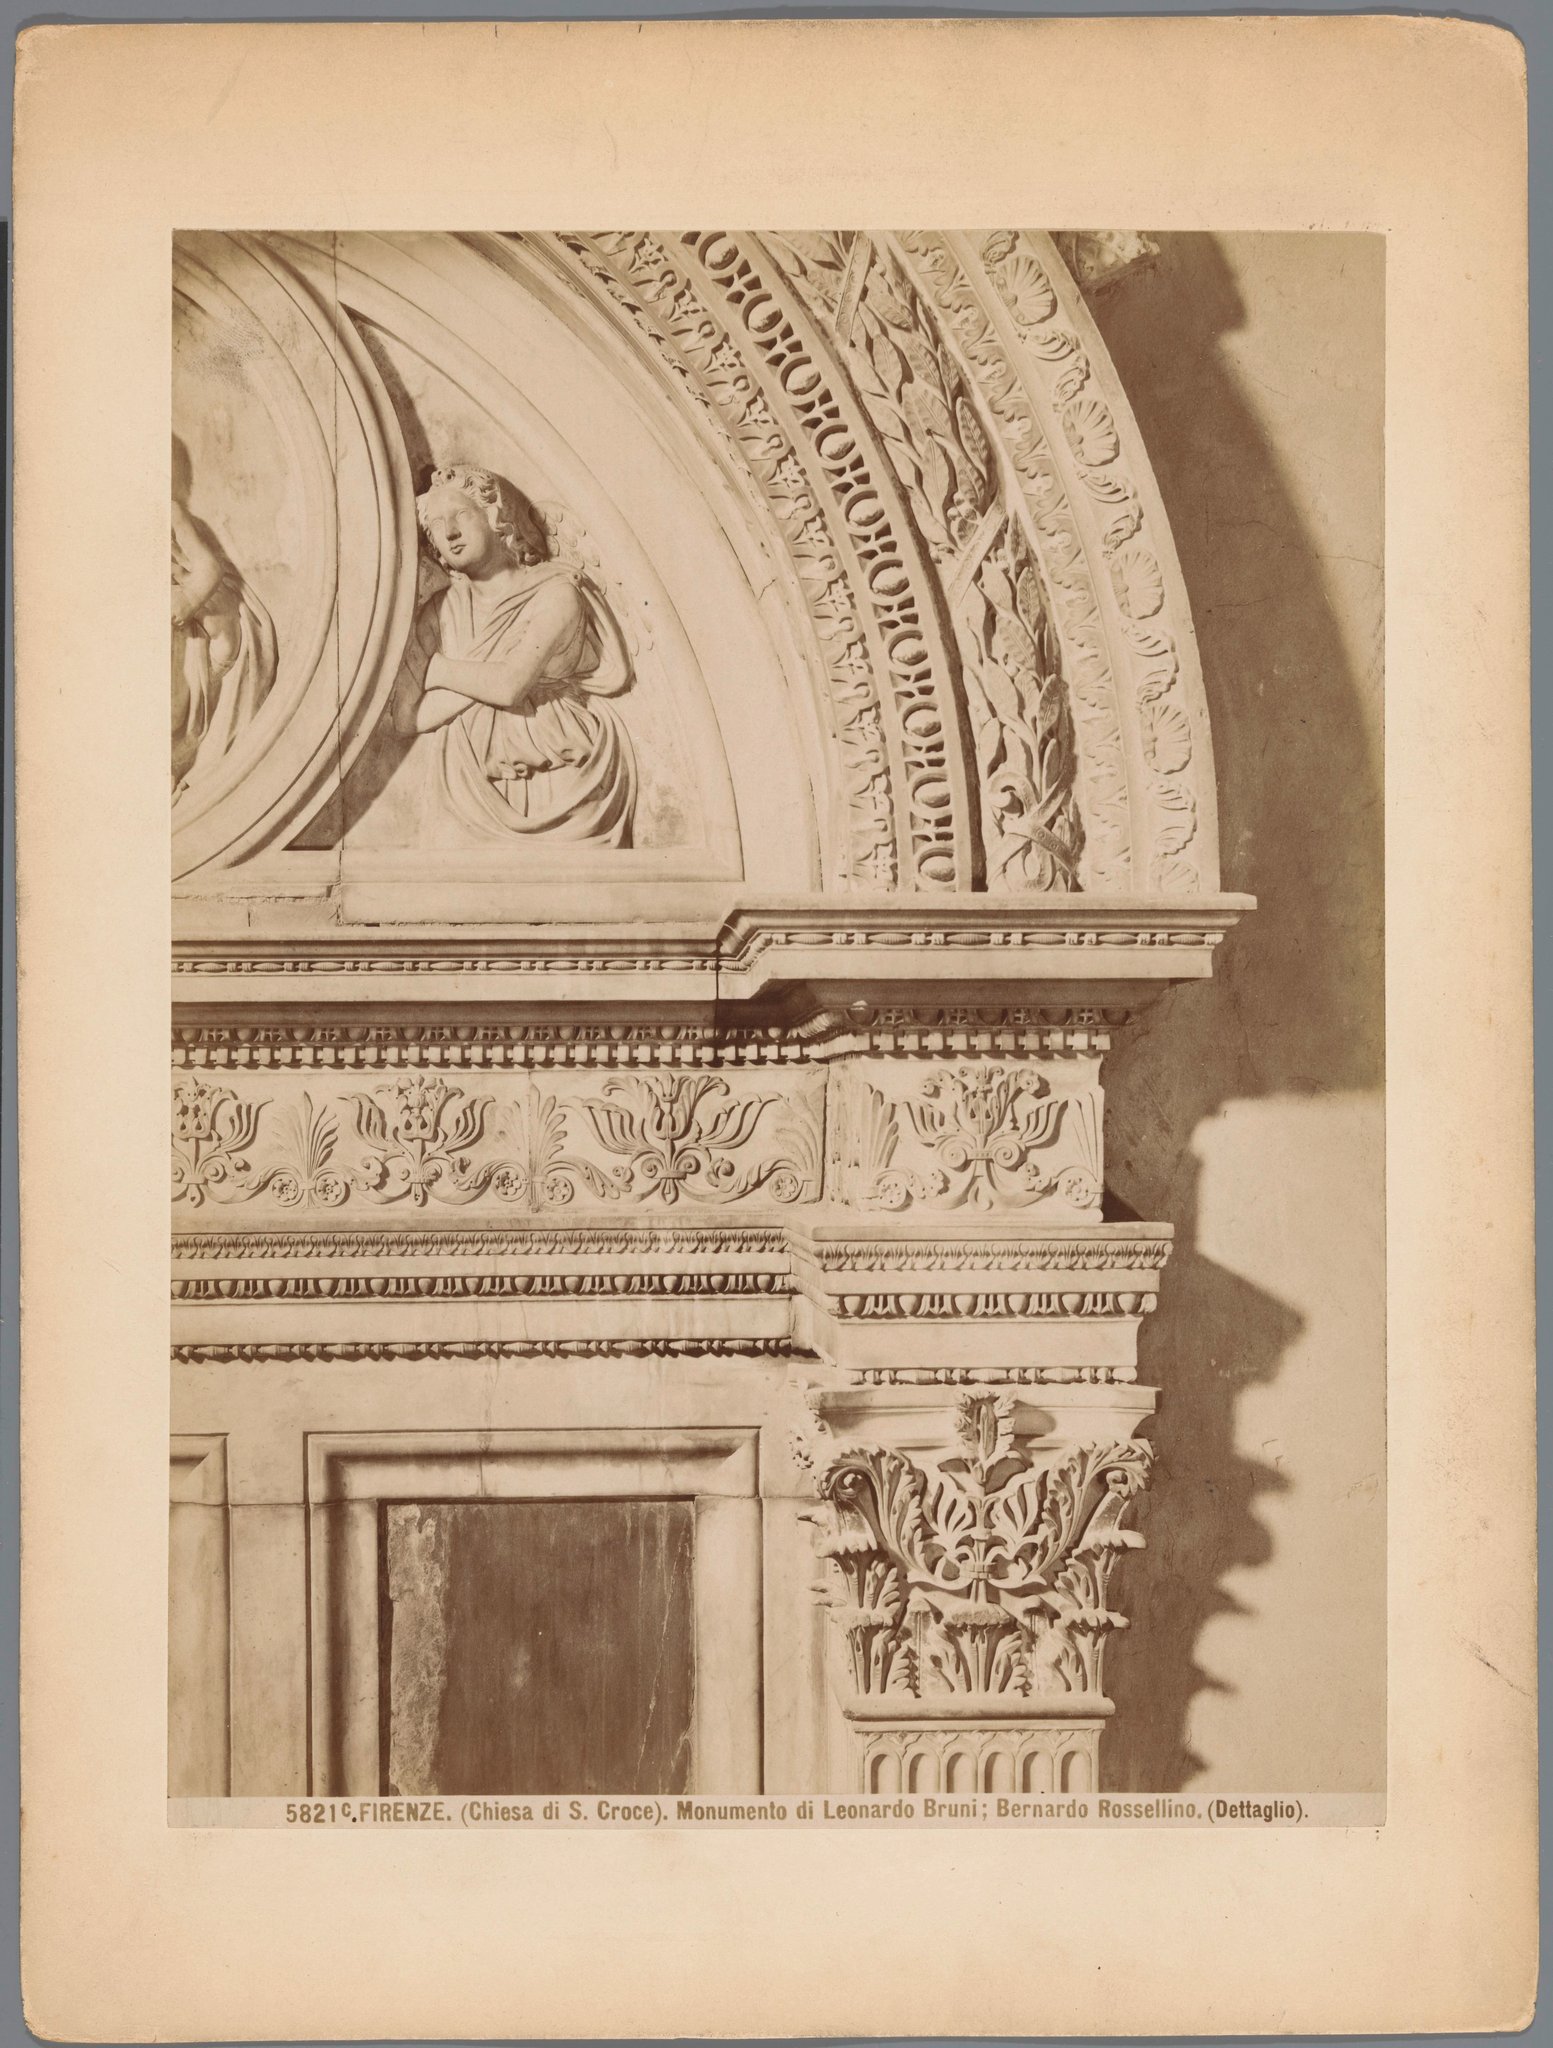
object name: photograph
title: Deel van de graftombe van Leonardo Bruni in de Santa Croce te Florence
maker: Anonymous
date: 1875-1900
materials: cardboard, photographic support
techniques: albumen print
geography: santa croce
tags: ornaments ~ art, acanthus ~ ornament, interior of church, grave-building, monumental tomb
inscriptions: collector's mark: Lugt 3937, number: ‘5821 c.’